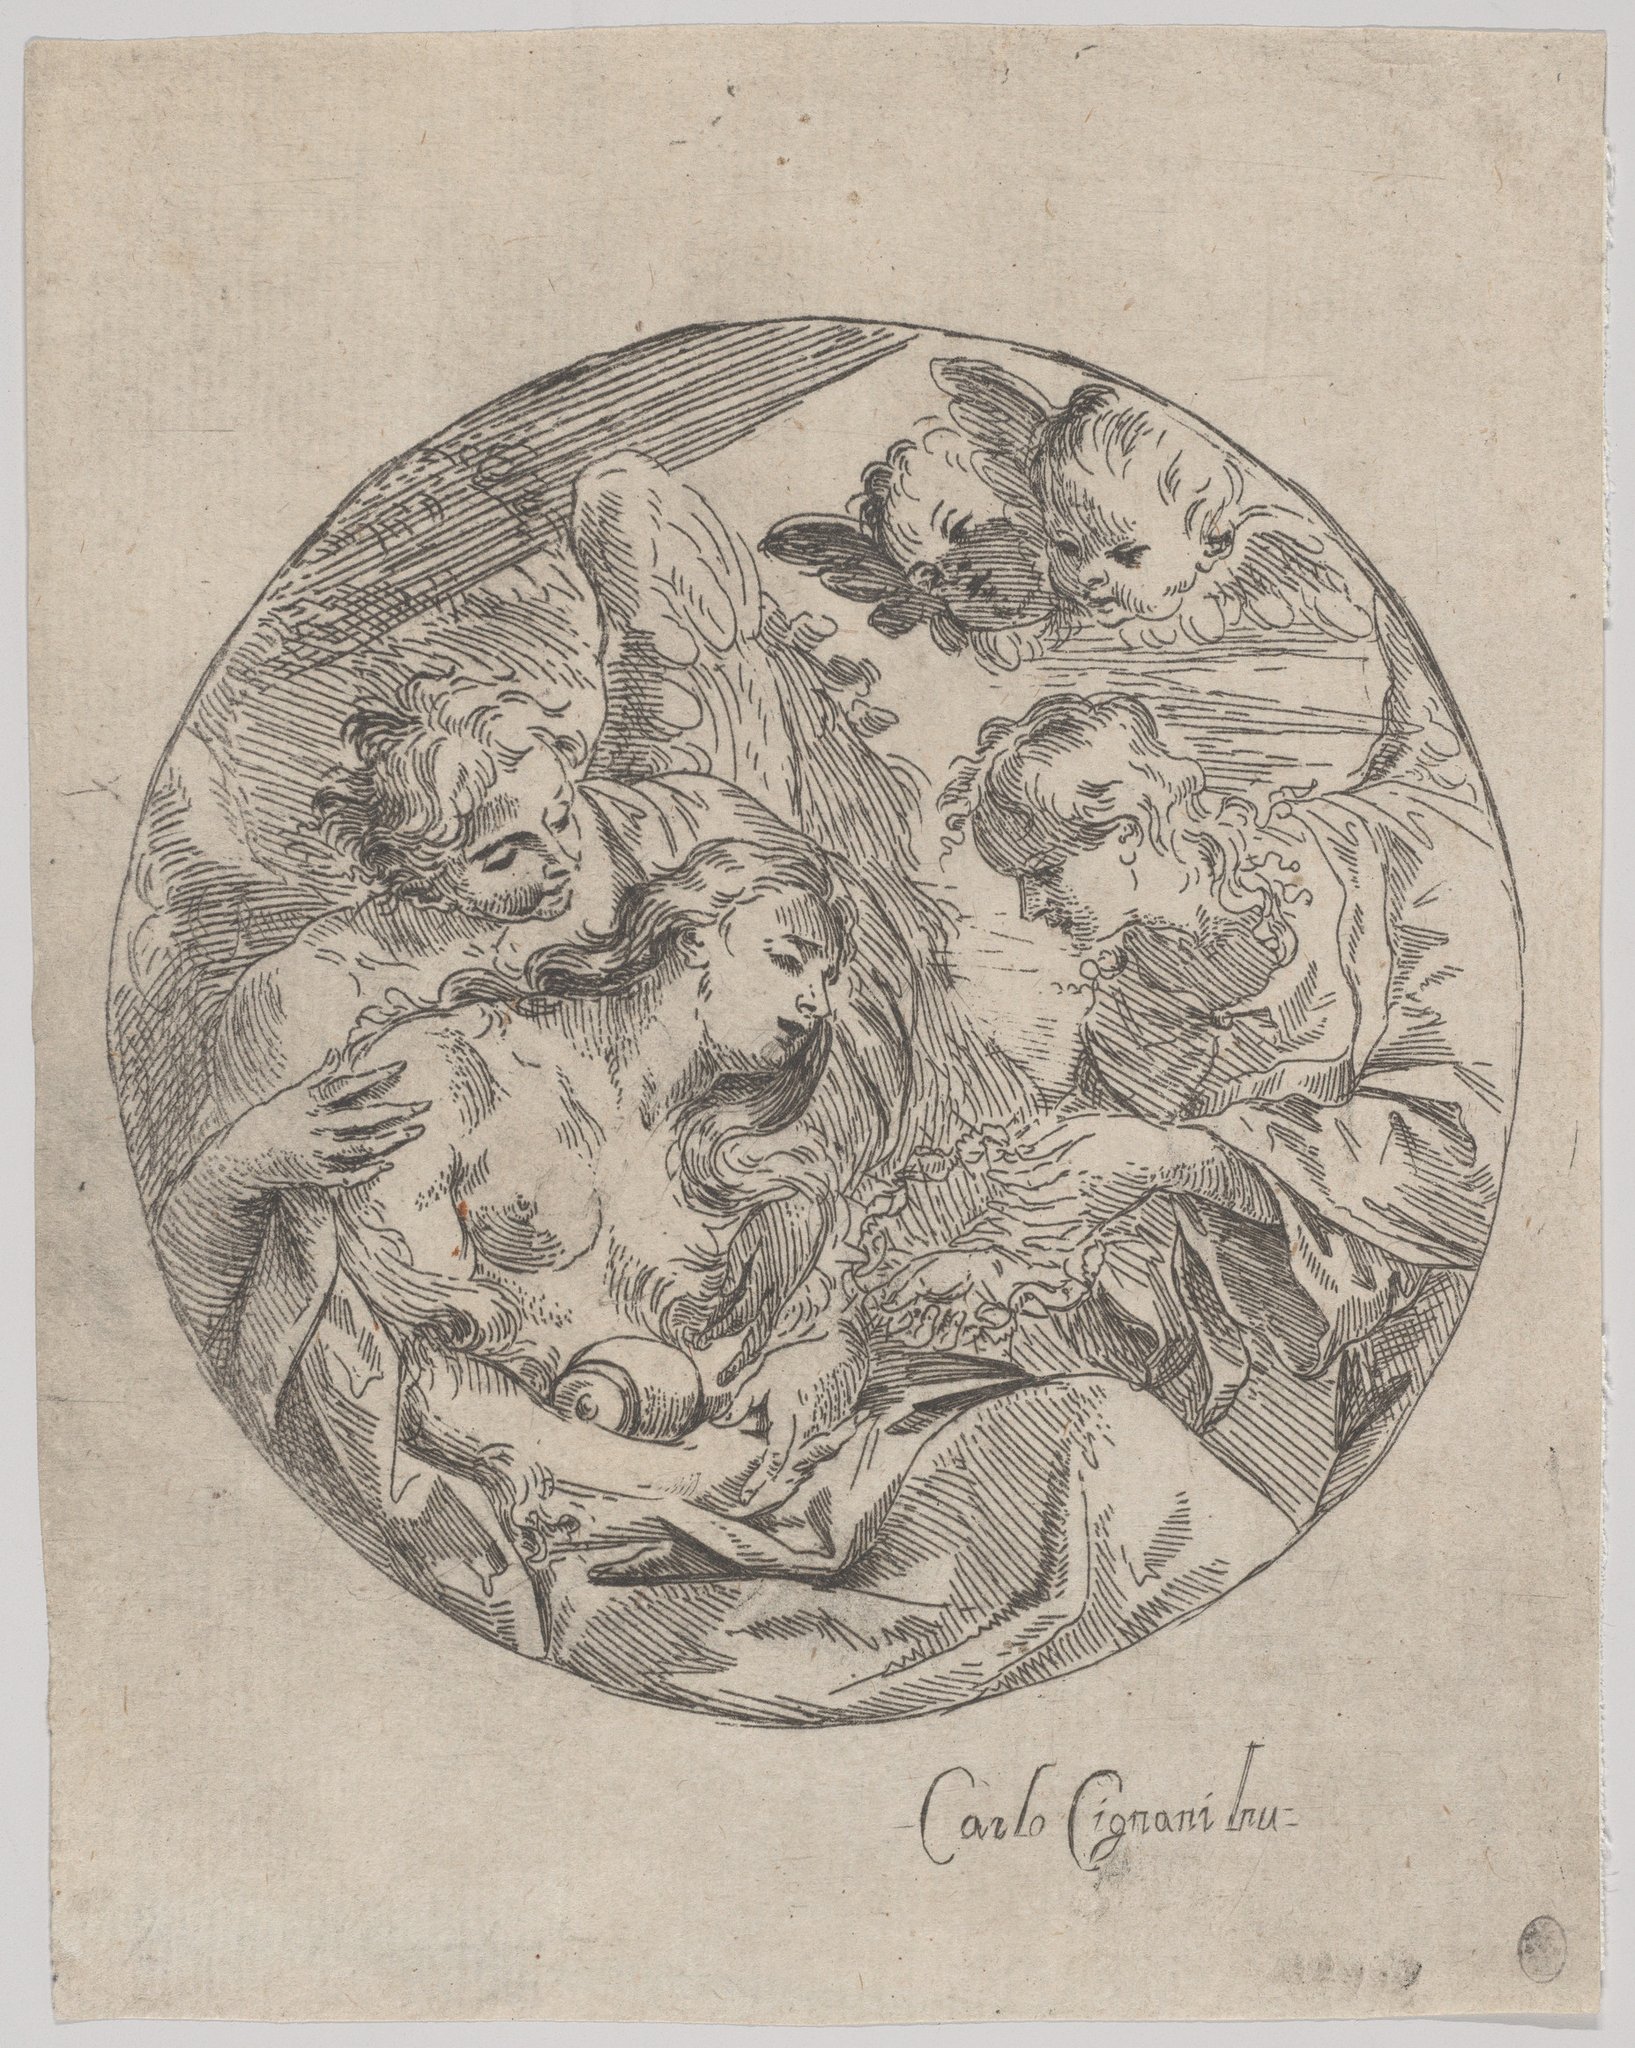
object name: print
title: The Death of Saint Mary Magdalene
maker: giuseppe antonio caccioli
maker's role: artist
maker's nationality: italian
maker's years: 1672-1740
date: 1692-1740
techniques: etching